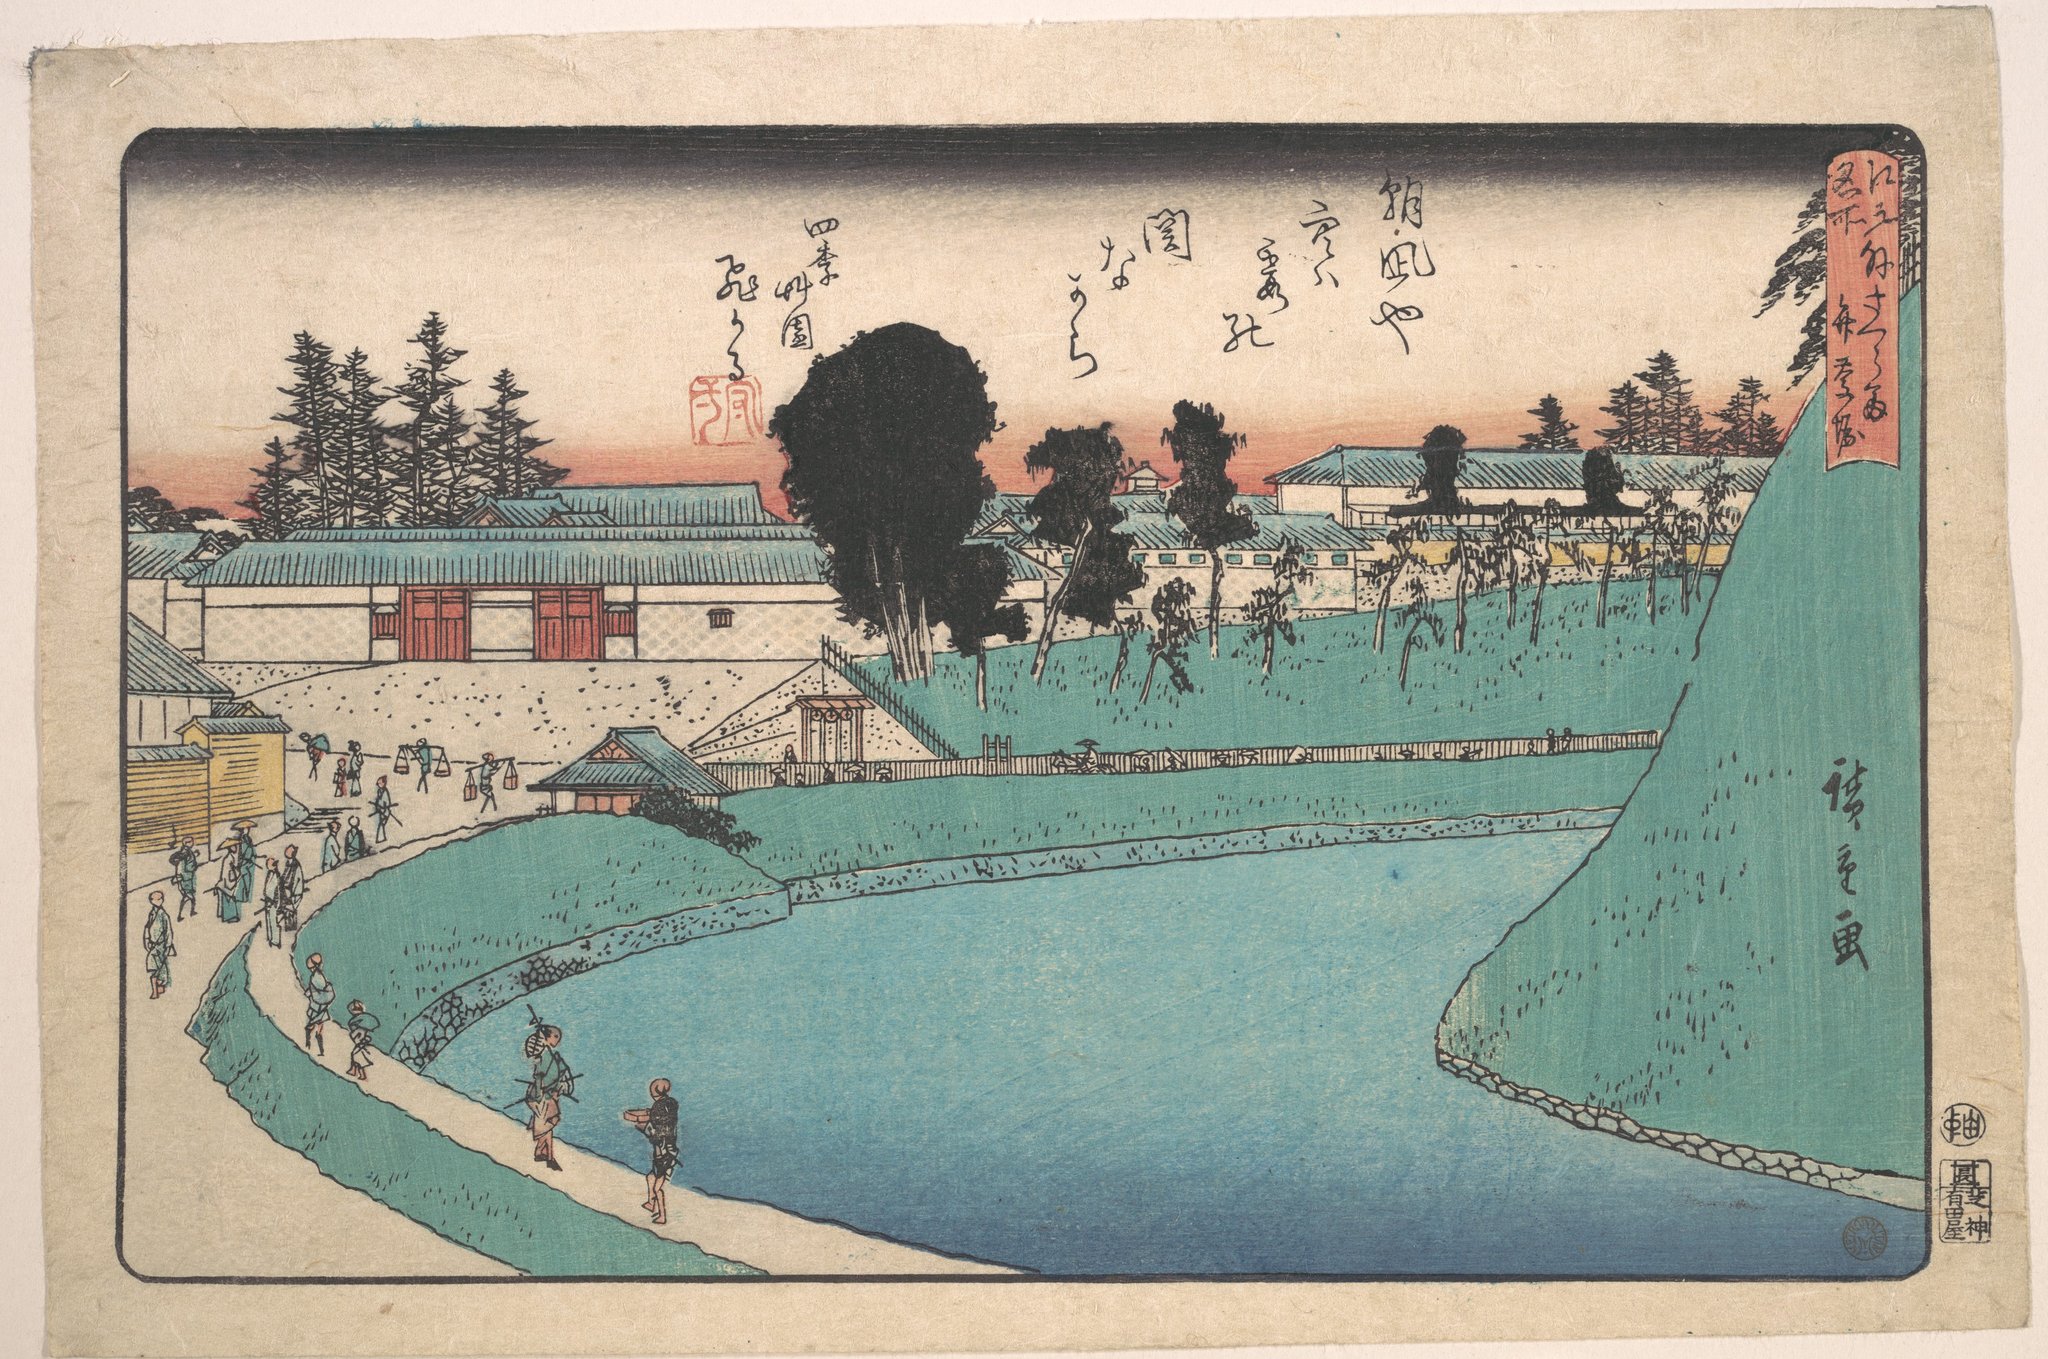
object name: print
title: Soto Sakurada Benkei Bori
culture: japanese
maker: utagawa hiroshige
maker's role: artist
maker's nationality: japanese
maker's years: 1797-1858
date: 1843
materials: ink, paper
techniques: woodblock print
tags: moats